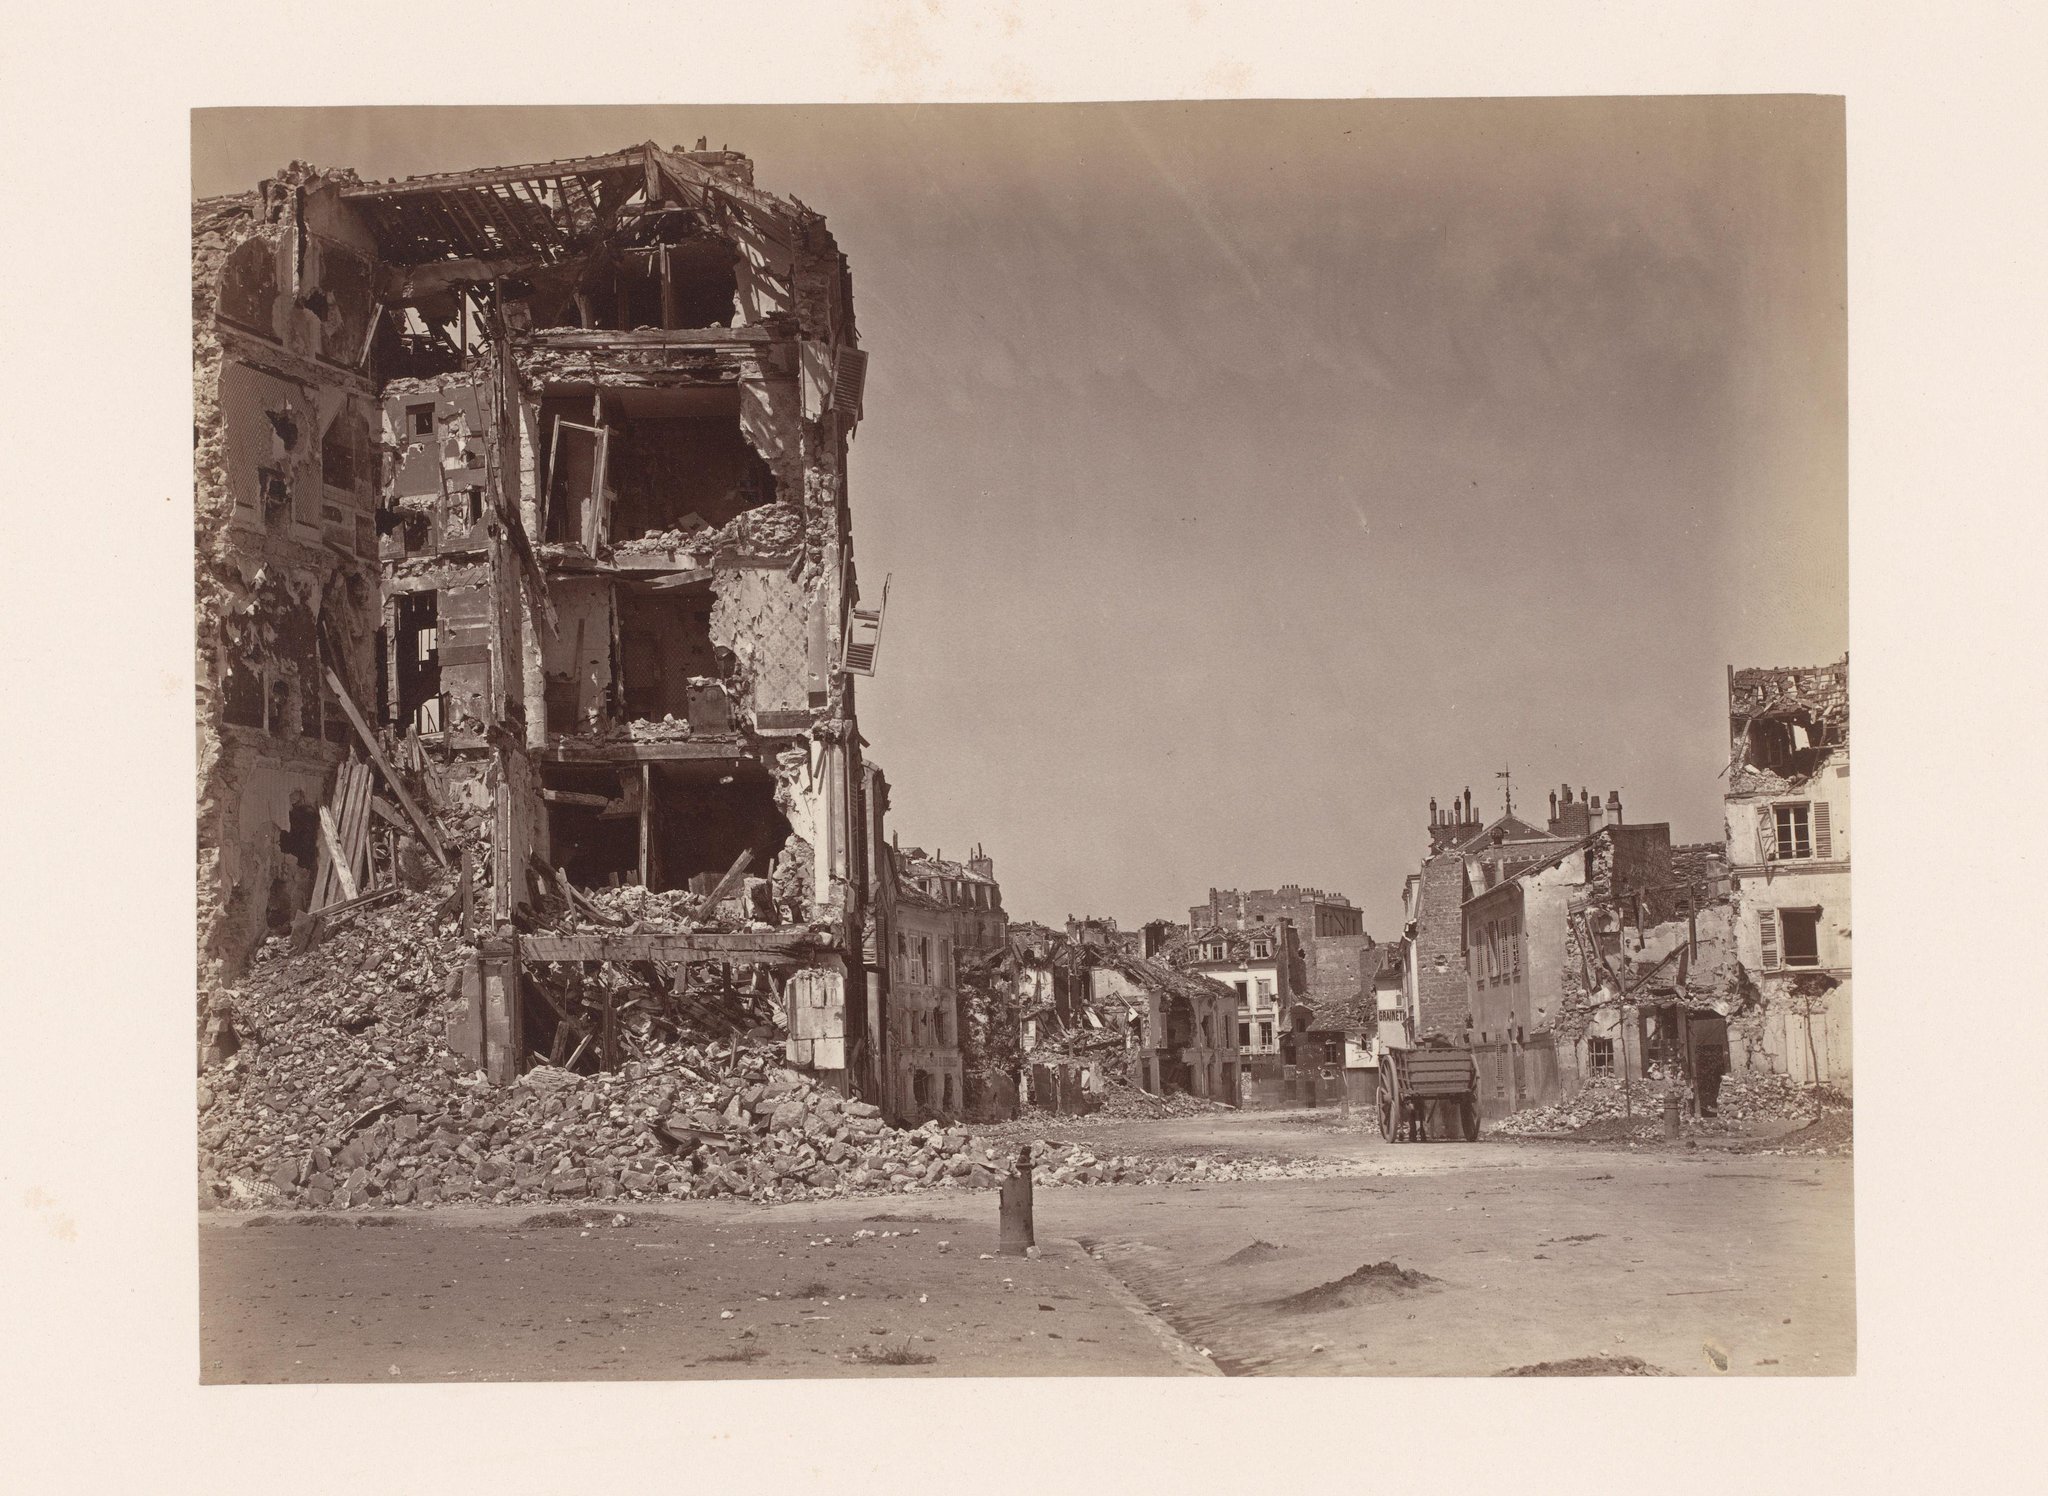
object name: photograph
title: Gezicht in de Avenue du Roule, Neuilly, Parijs, met aan weerszijden ruïnes van gebouwen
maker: charles soulier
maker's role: fotograaf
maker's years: 1840-1876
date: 1871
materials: paper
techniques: albumen print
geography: france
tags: devastated, ruined place or city (~ warfare), paris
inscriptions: label: ‘(gedrukt): 1871 / INSURRECTION DE PARIS / Avenue du Roule / Neuilly; (in potlood): 32’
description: De gebouwen werden verwoest tijdens de Commune-opstand.